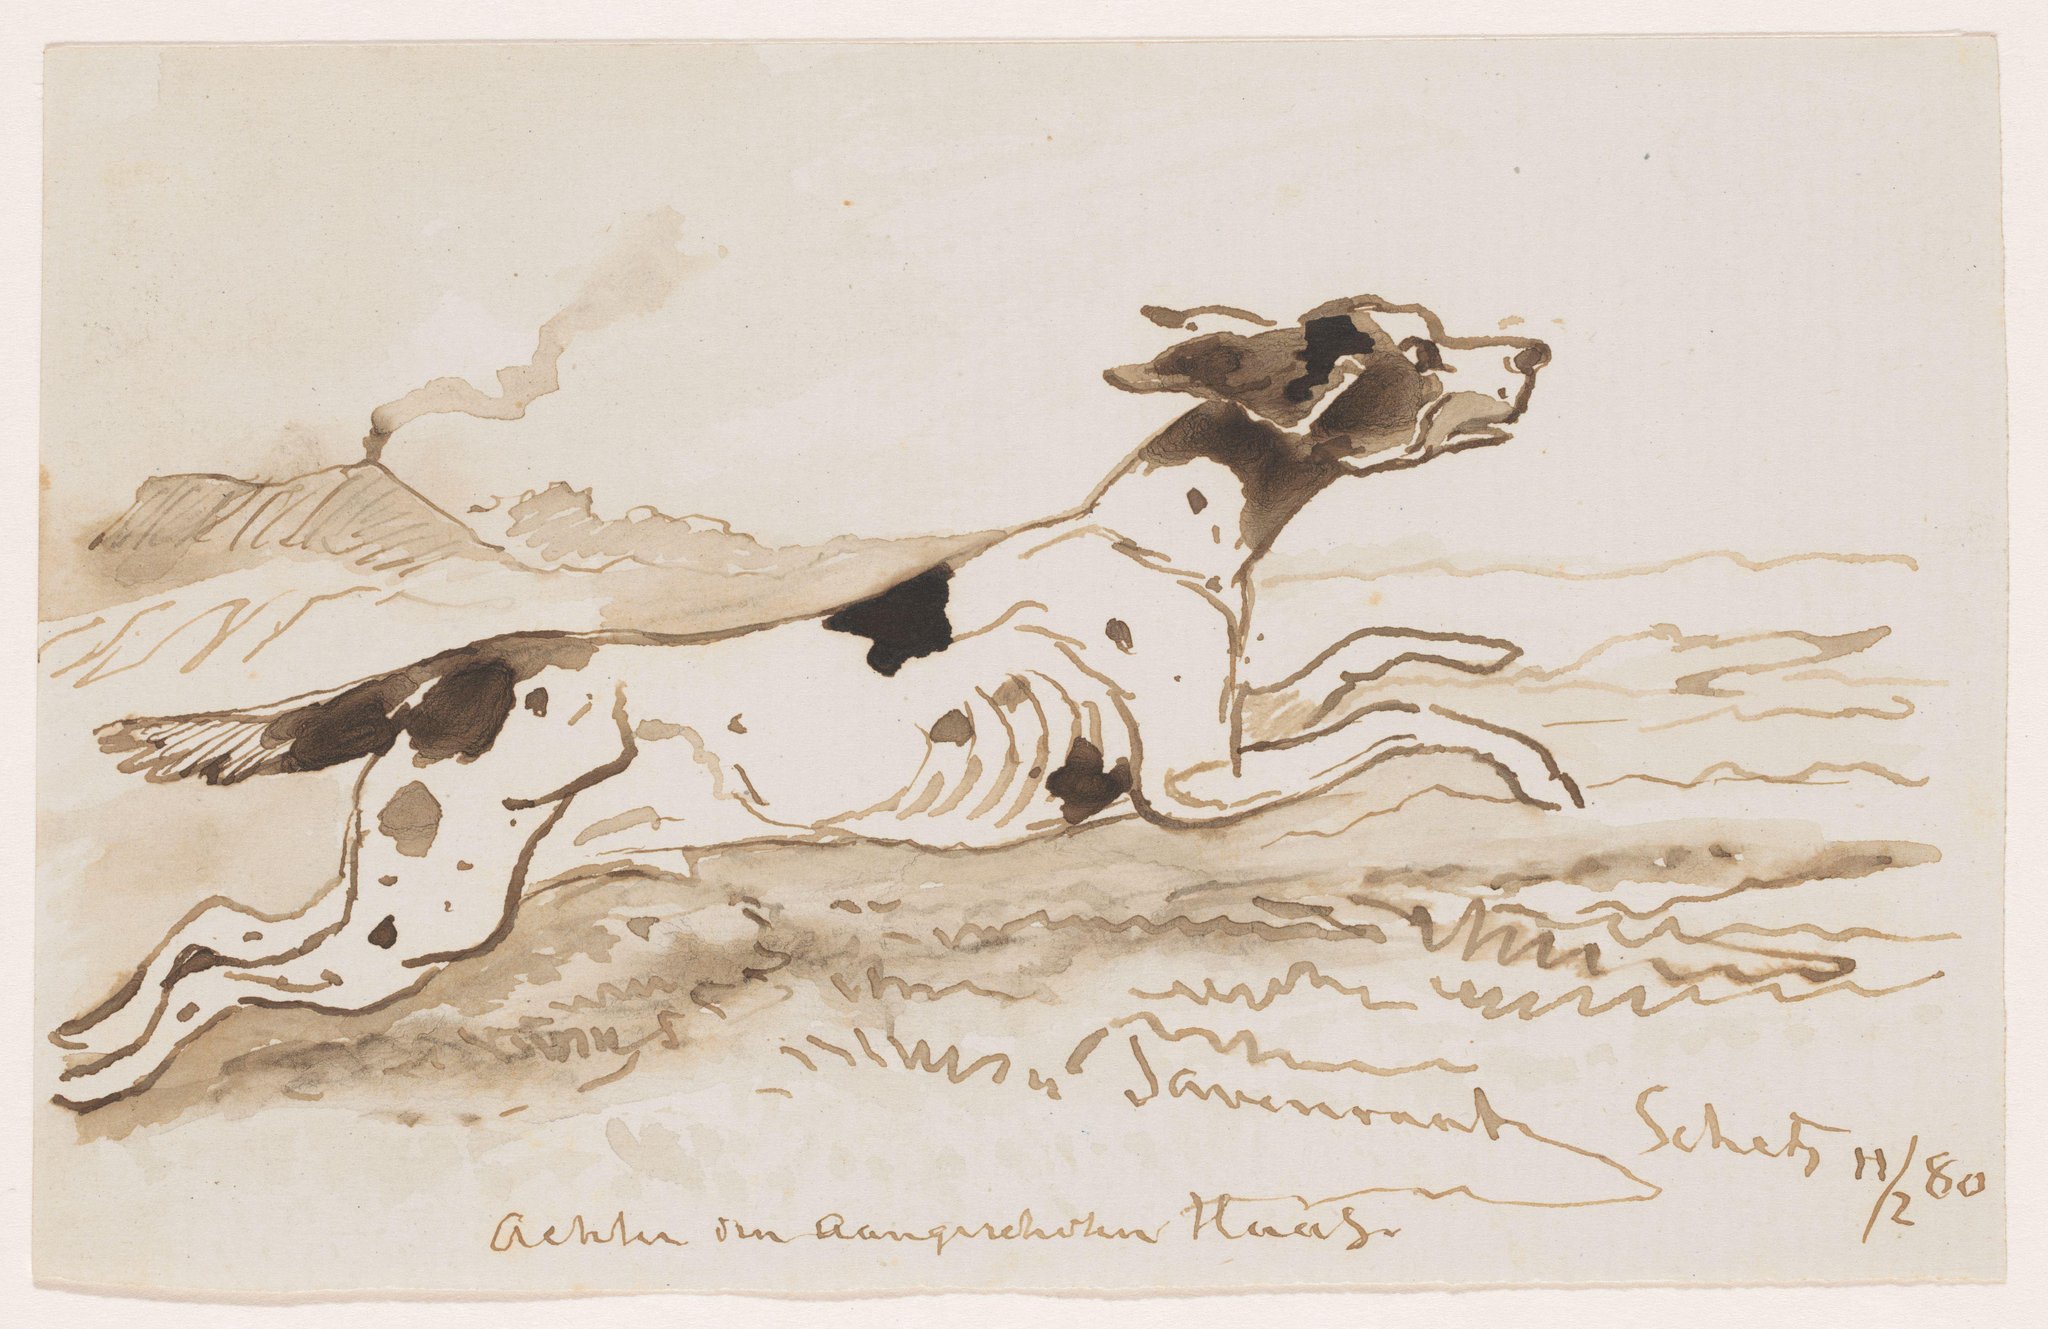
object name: drawing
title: Achter een aangeschoten Haas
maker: johannes tavenraat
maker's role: draughtsman, painter, print maker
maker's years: 1809-1881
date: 1880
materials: ink, paper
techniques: brush, pen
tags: hunting dogs, hare-hunting, rabbit-hunting, dog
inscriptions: collector's mark: Lugt 2228, annotation: ‘Achter een aangeschoten Haas.’, signature and date: ‘Tavenraat 11/2 80.’